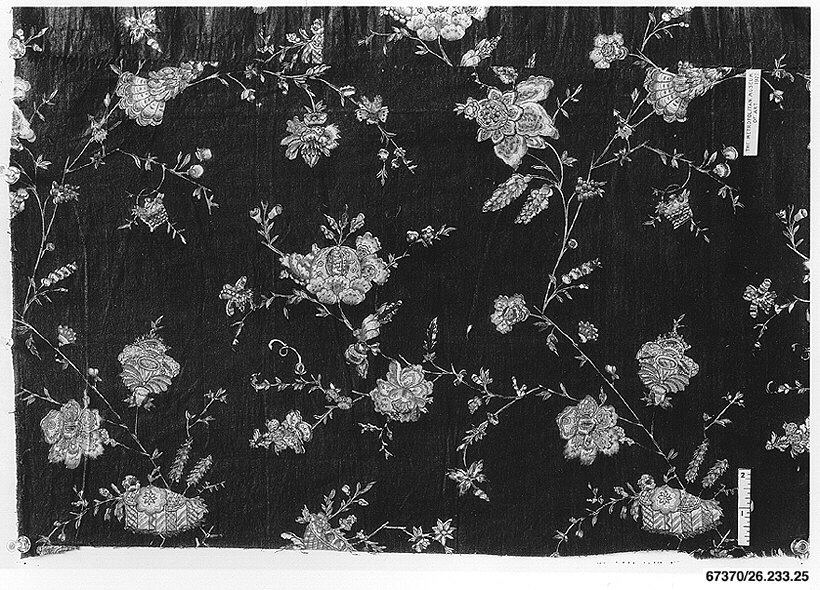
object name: piece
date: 1775-1780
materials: cotton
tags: flowers,leaves